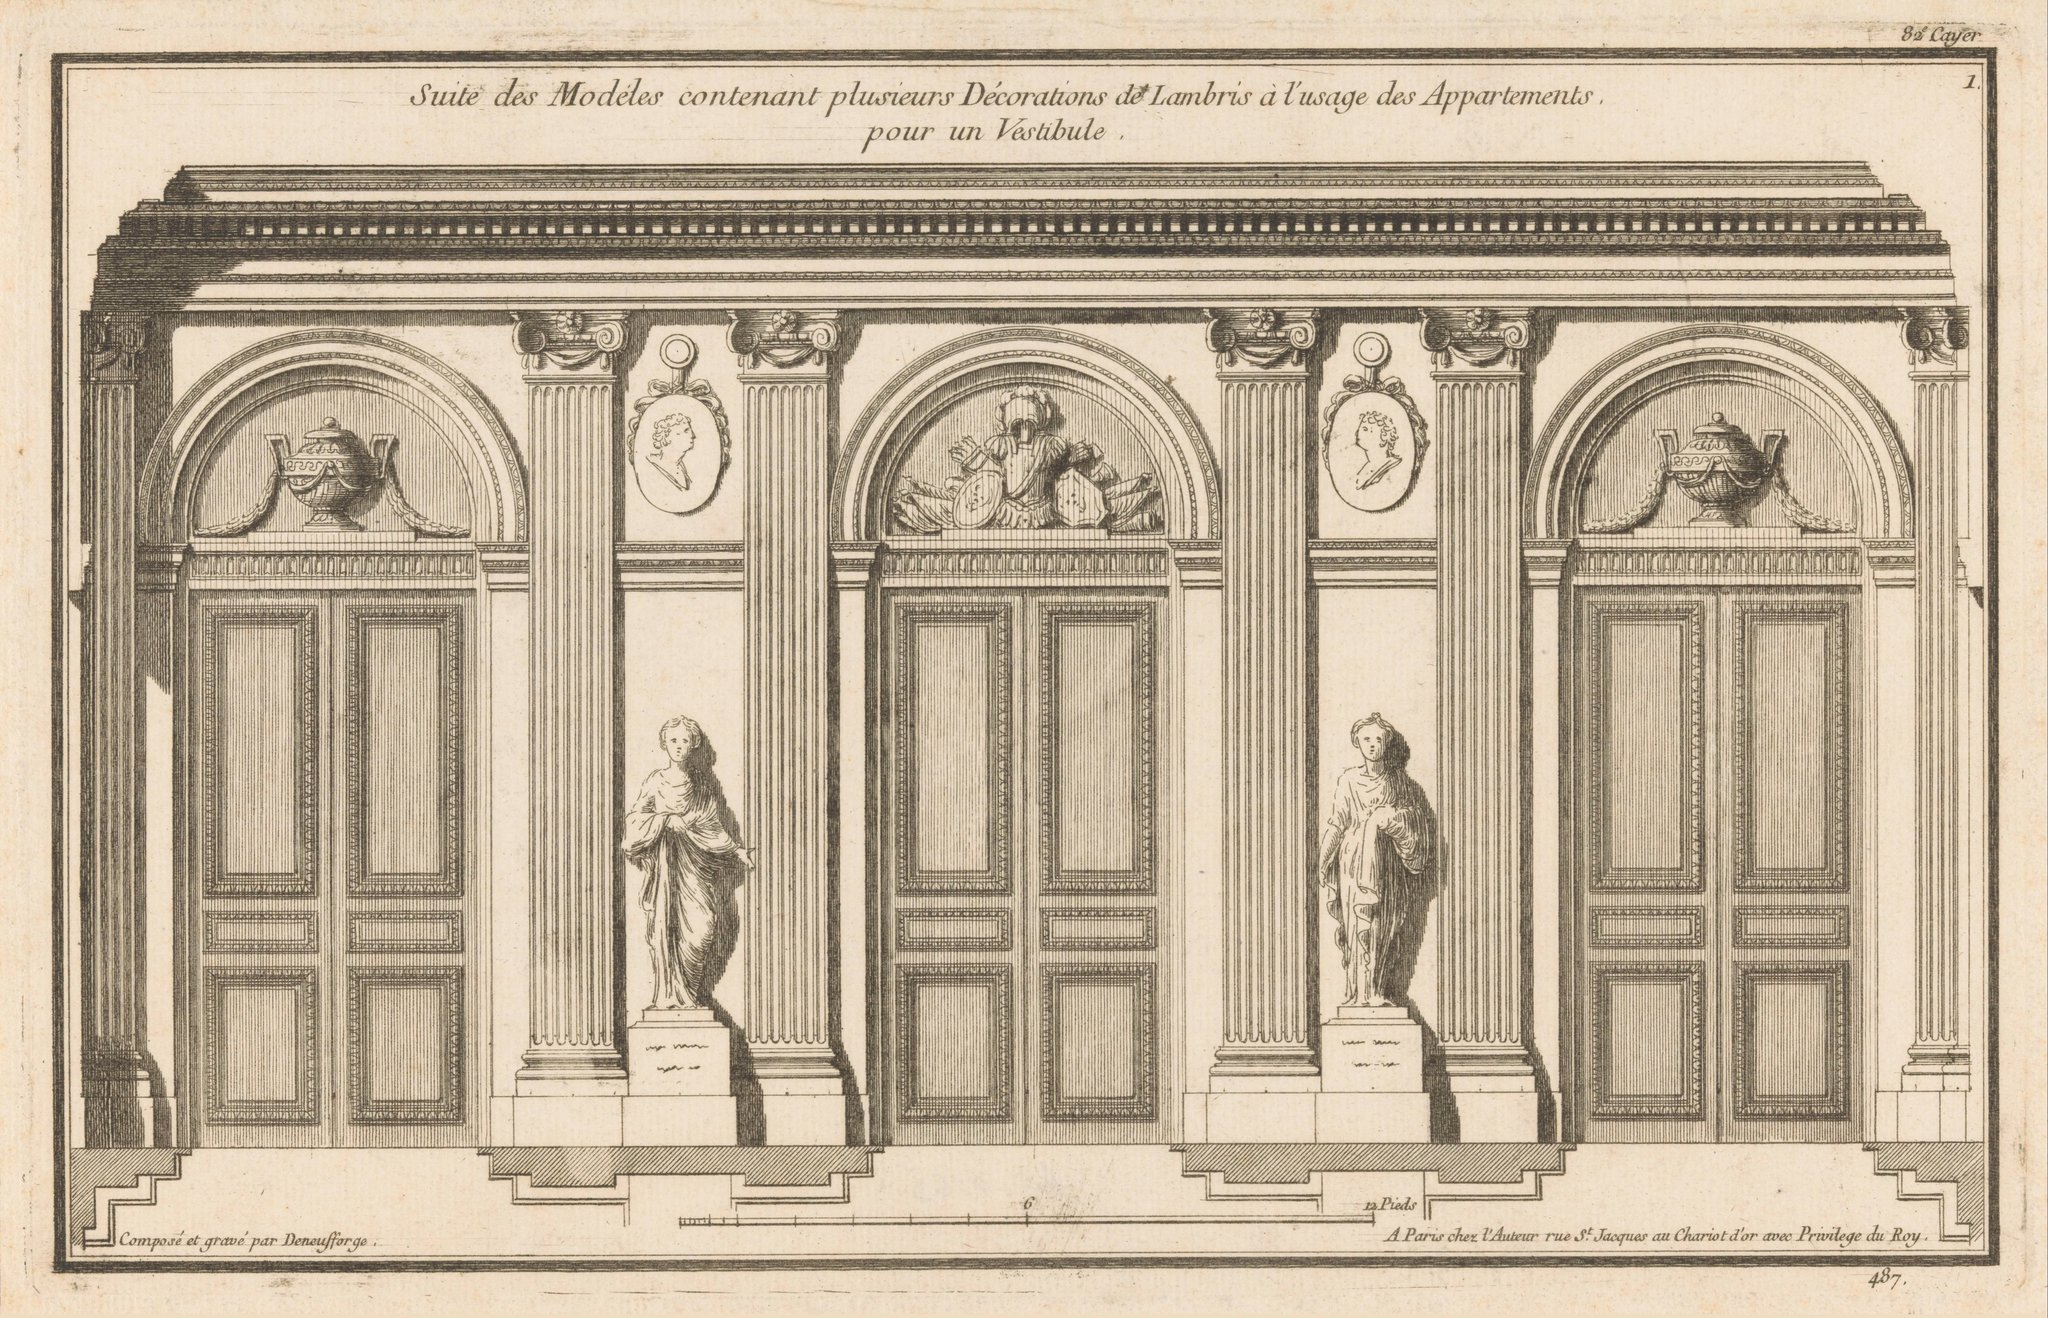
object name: print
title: 82e Cayer Suite des Modeles contenant plusieurs Décorations de Lambris a l'usage des Appartements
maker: jean françois de neufforge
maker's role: print maker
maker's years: 1714-1791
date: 1767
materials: paper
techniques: etching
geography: paris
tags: vestibule, hall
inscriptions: collector's mark: Lugt 2760, collector's mark: Lugt 2228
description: Een vestibule met pilasters, drie deuren, twee beelden en medaillons met portretten. Boven de deuren dessus-de-portes met vazen en een harnas met wapens. Prentnummer 487.